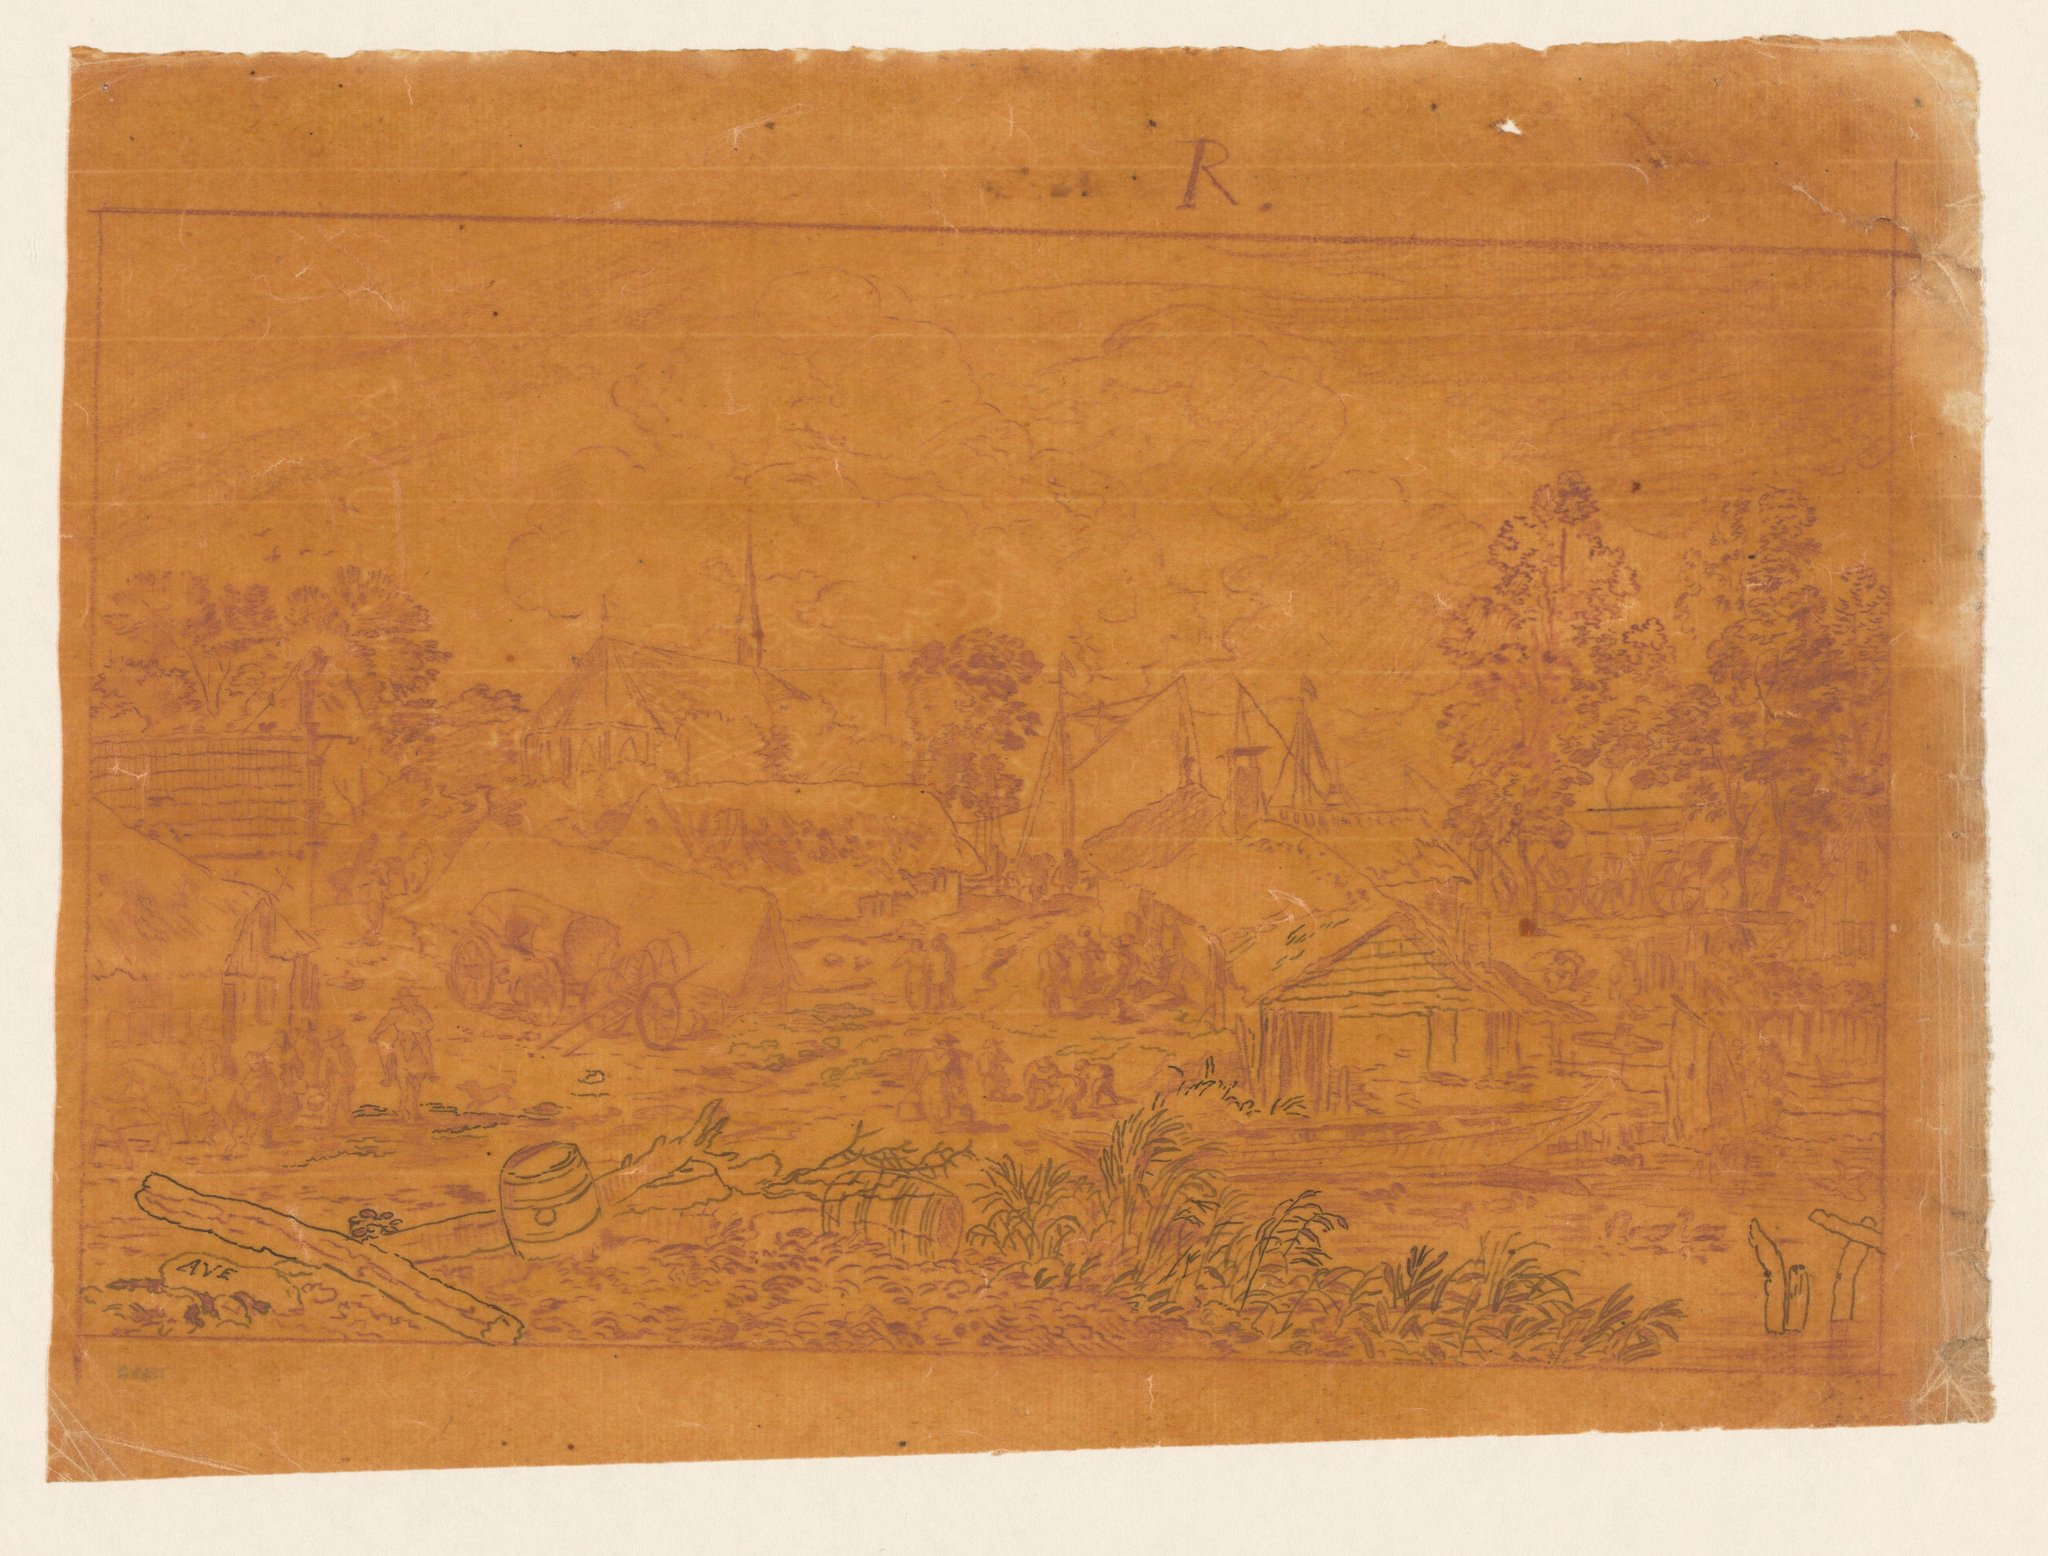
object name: tracing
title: Dorpsgezicht met vijver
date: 1782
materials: chalk, ink, paper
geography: amsterdam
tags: village, pond, pool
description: Een dorp met rechts op de voorgrond een vijver. Op de achtergrond de zeilen en masten van schepen. De calque ligt los in een album, zie blad 36.